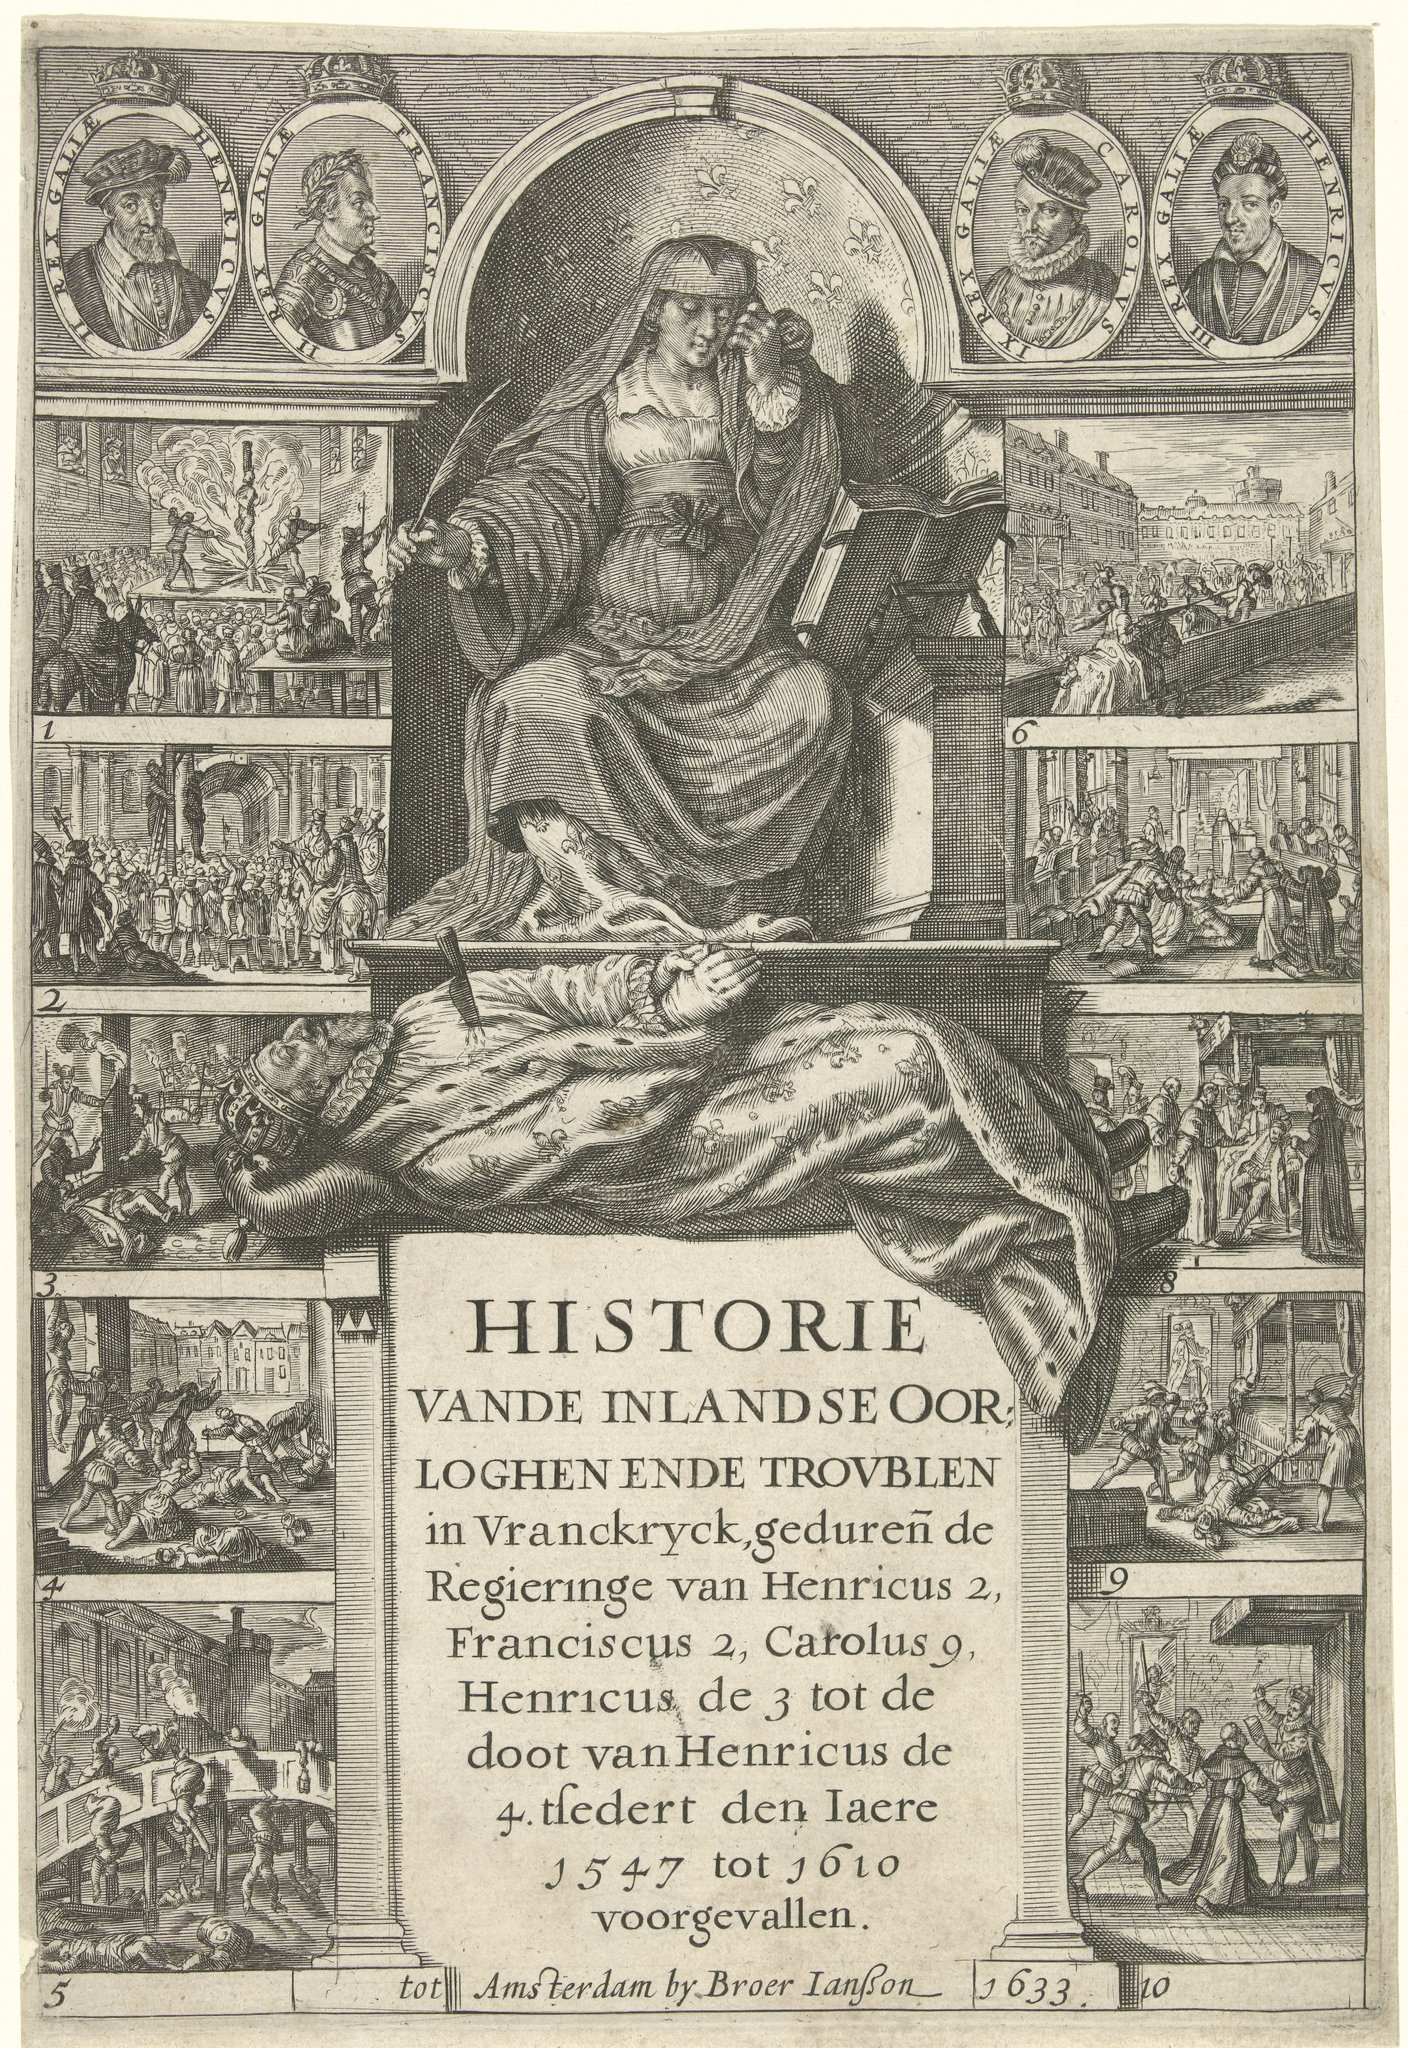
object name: print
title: Titelpagina voor: Historie van de Inlandse Oorloghen en de Troublen in Vranckryck, 1633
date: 1633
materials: paper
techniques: engraving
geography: utrecht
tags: hendrik iii (koning van frankrijk), karel ix (koning van frankrijk), paris, hendrik iv (koning van frankrijk en navarra), frontispiece, 'historia'; 'historia' (ripa), violent death by dagger, knife, historical events and situations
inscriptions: collector's mark: Lugt 2228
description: Nis met de vrouwelijke personificatie van Geschiedenis die treurt om de vermoorde Hendrik IV, die neergestoken aan haar voeten ligt. Bovenaan in ovale omlijstingen de portretten van vier Franse koningen, respectievelijk: Hendrik II, Frans II, Karel IX en Hendrik III. Links en rechts tien genummerde historische scènes. In het kader tussen twee zuilen de titel in het Nederlands.